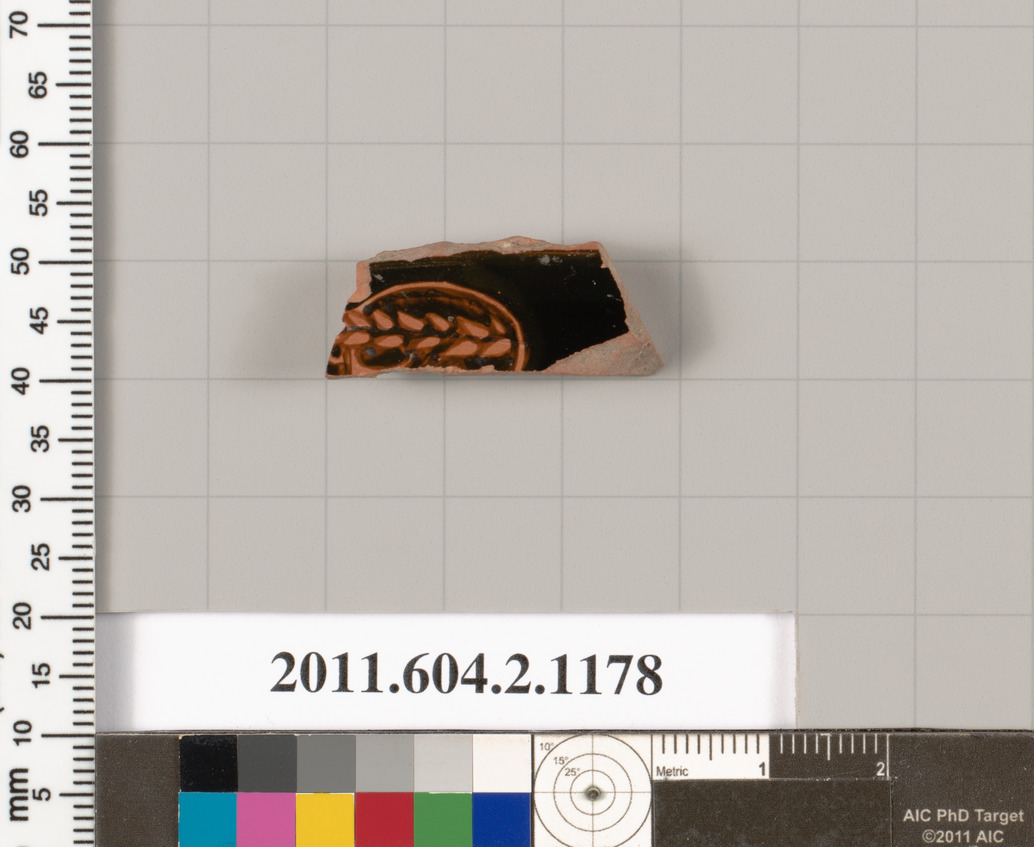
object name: pyxis fragment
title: Terracotta fragment from a pyxis (box)?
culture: greek, attic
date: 470-450 BCE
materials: terracotta